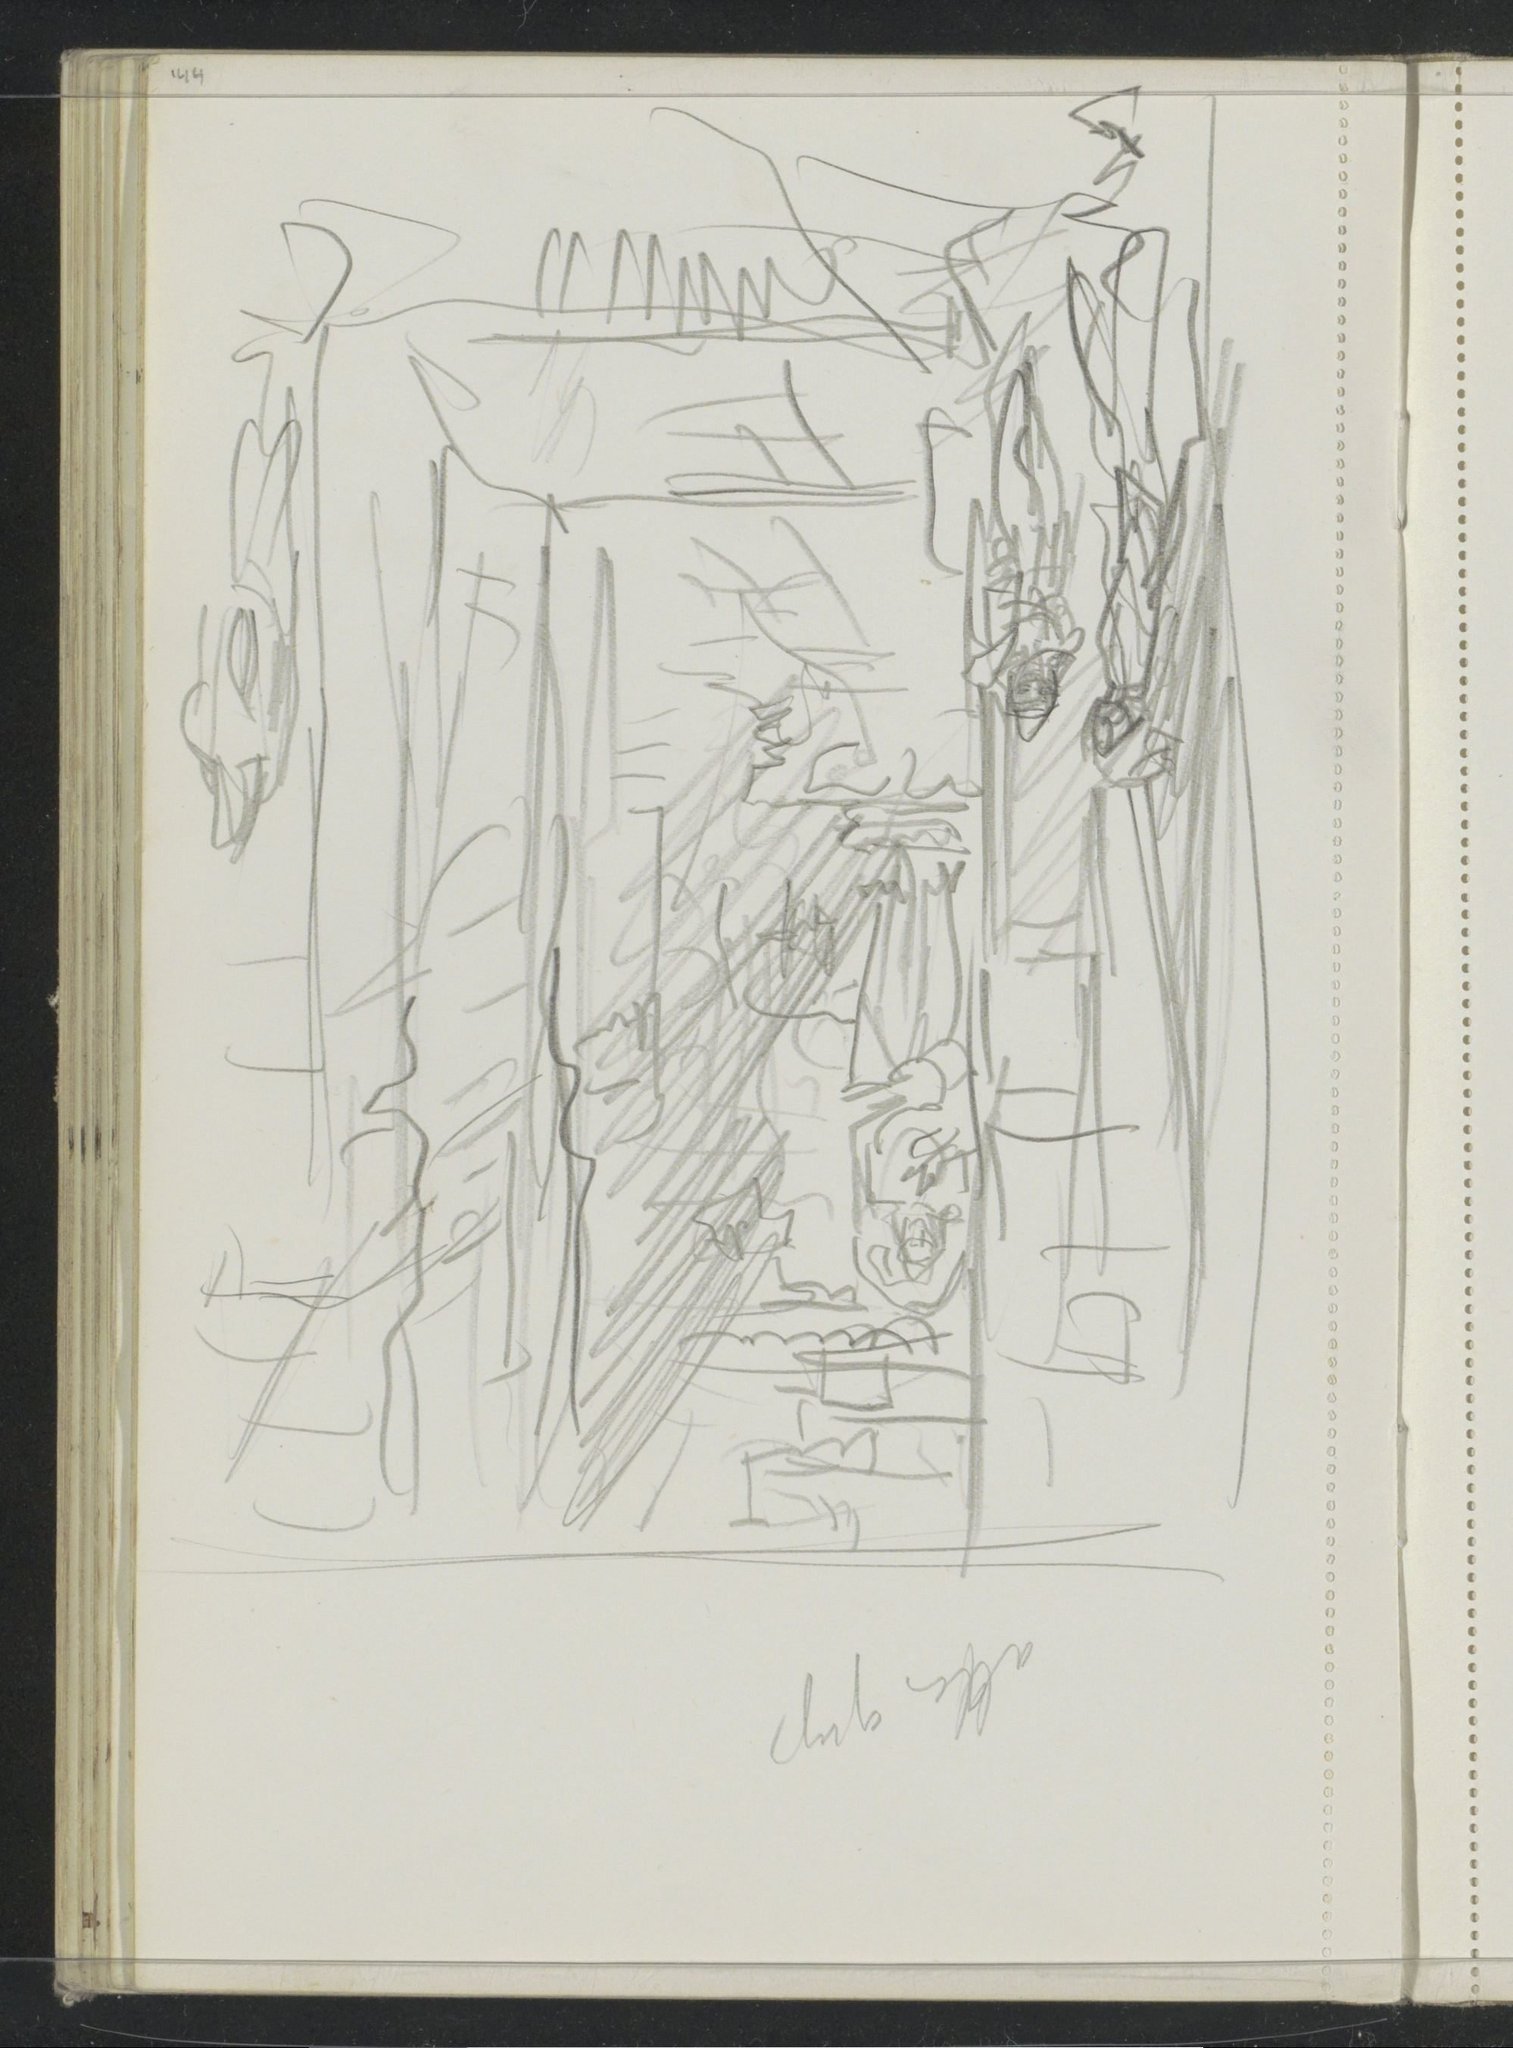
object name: sketchbook leaf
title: Figuren bij een godenbeeld in een nis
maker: marius bauer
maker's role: draughtsman, print maker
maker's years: 1867-1932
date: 1925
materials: paper, pencil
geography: indonesia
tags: asiatic races and peoples, altar ~ hinduism, buddhism, jainism, statues, paintings, etc. ~ objects of worship (hinduism, buddhism, jainism)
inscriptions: kleurnotitie, handgeschreven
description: Mogelijk een altaar in of bij een tempel. Pagina 144 uit een schetsboek met 74 bladen.